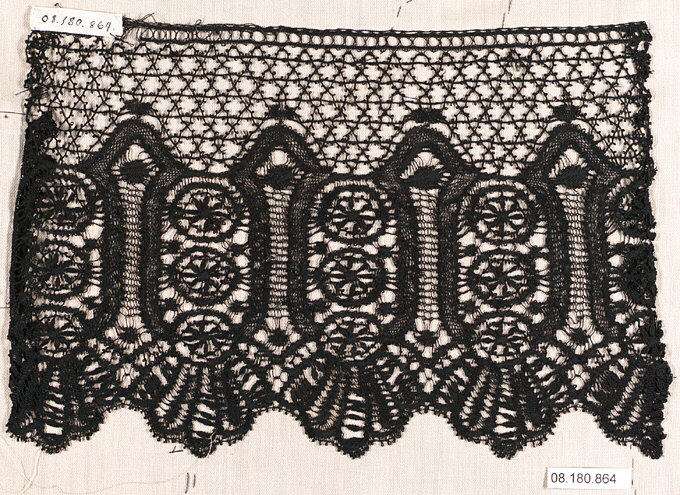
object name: piece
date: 1801-1900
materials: silk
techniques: lace